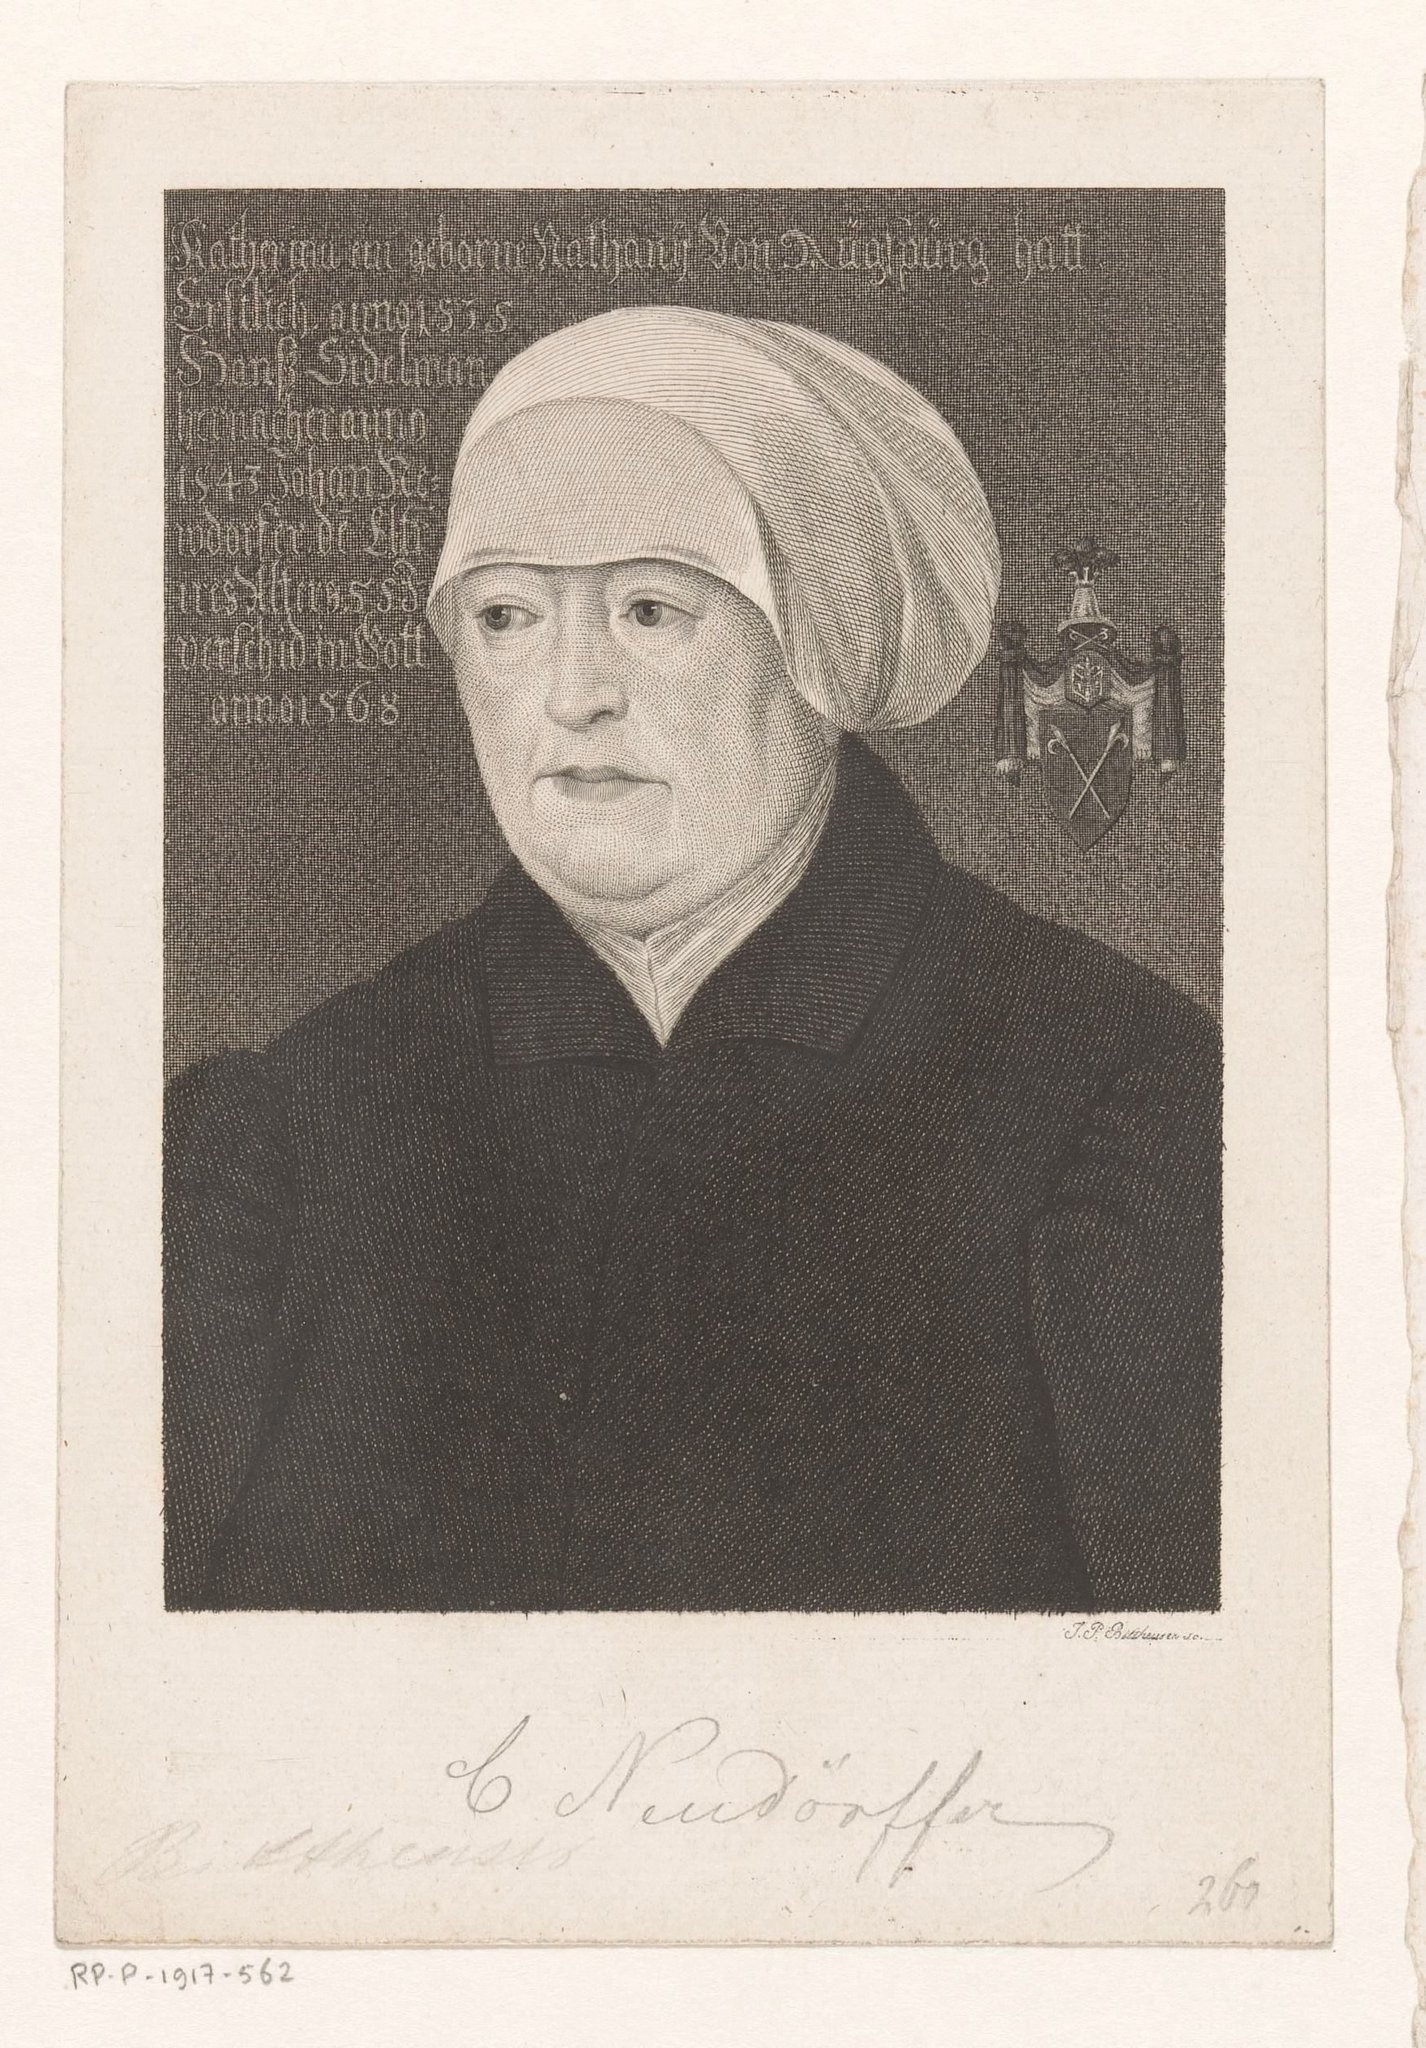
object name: print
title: Portret van Katharina Neudörffer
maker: johann pleikhard bittheuser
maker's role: print maker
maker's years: 1774-1859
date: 1821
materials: paper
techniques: engraving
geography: würzburg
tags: historical persons - bb - woman, armorial bearing, heraldry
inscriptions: collector's mark: Lugt 2228